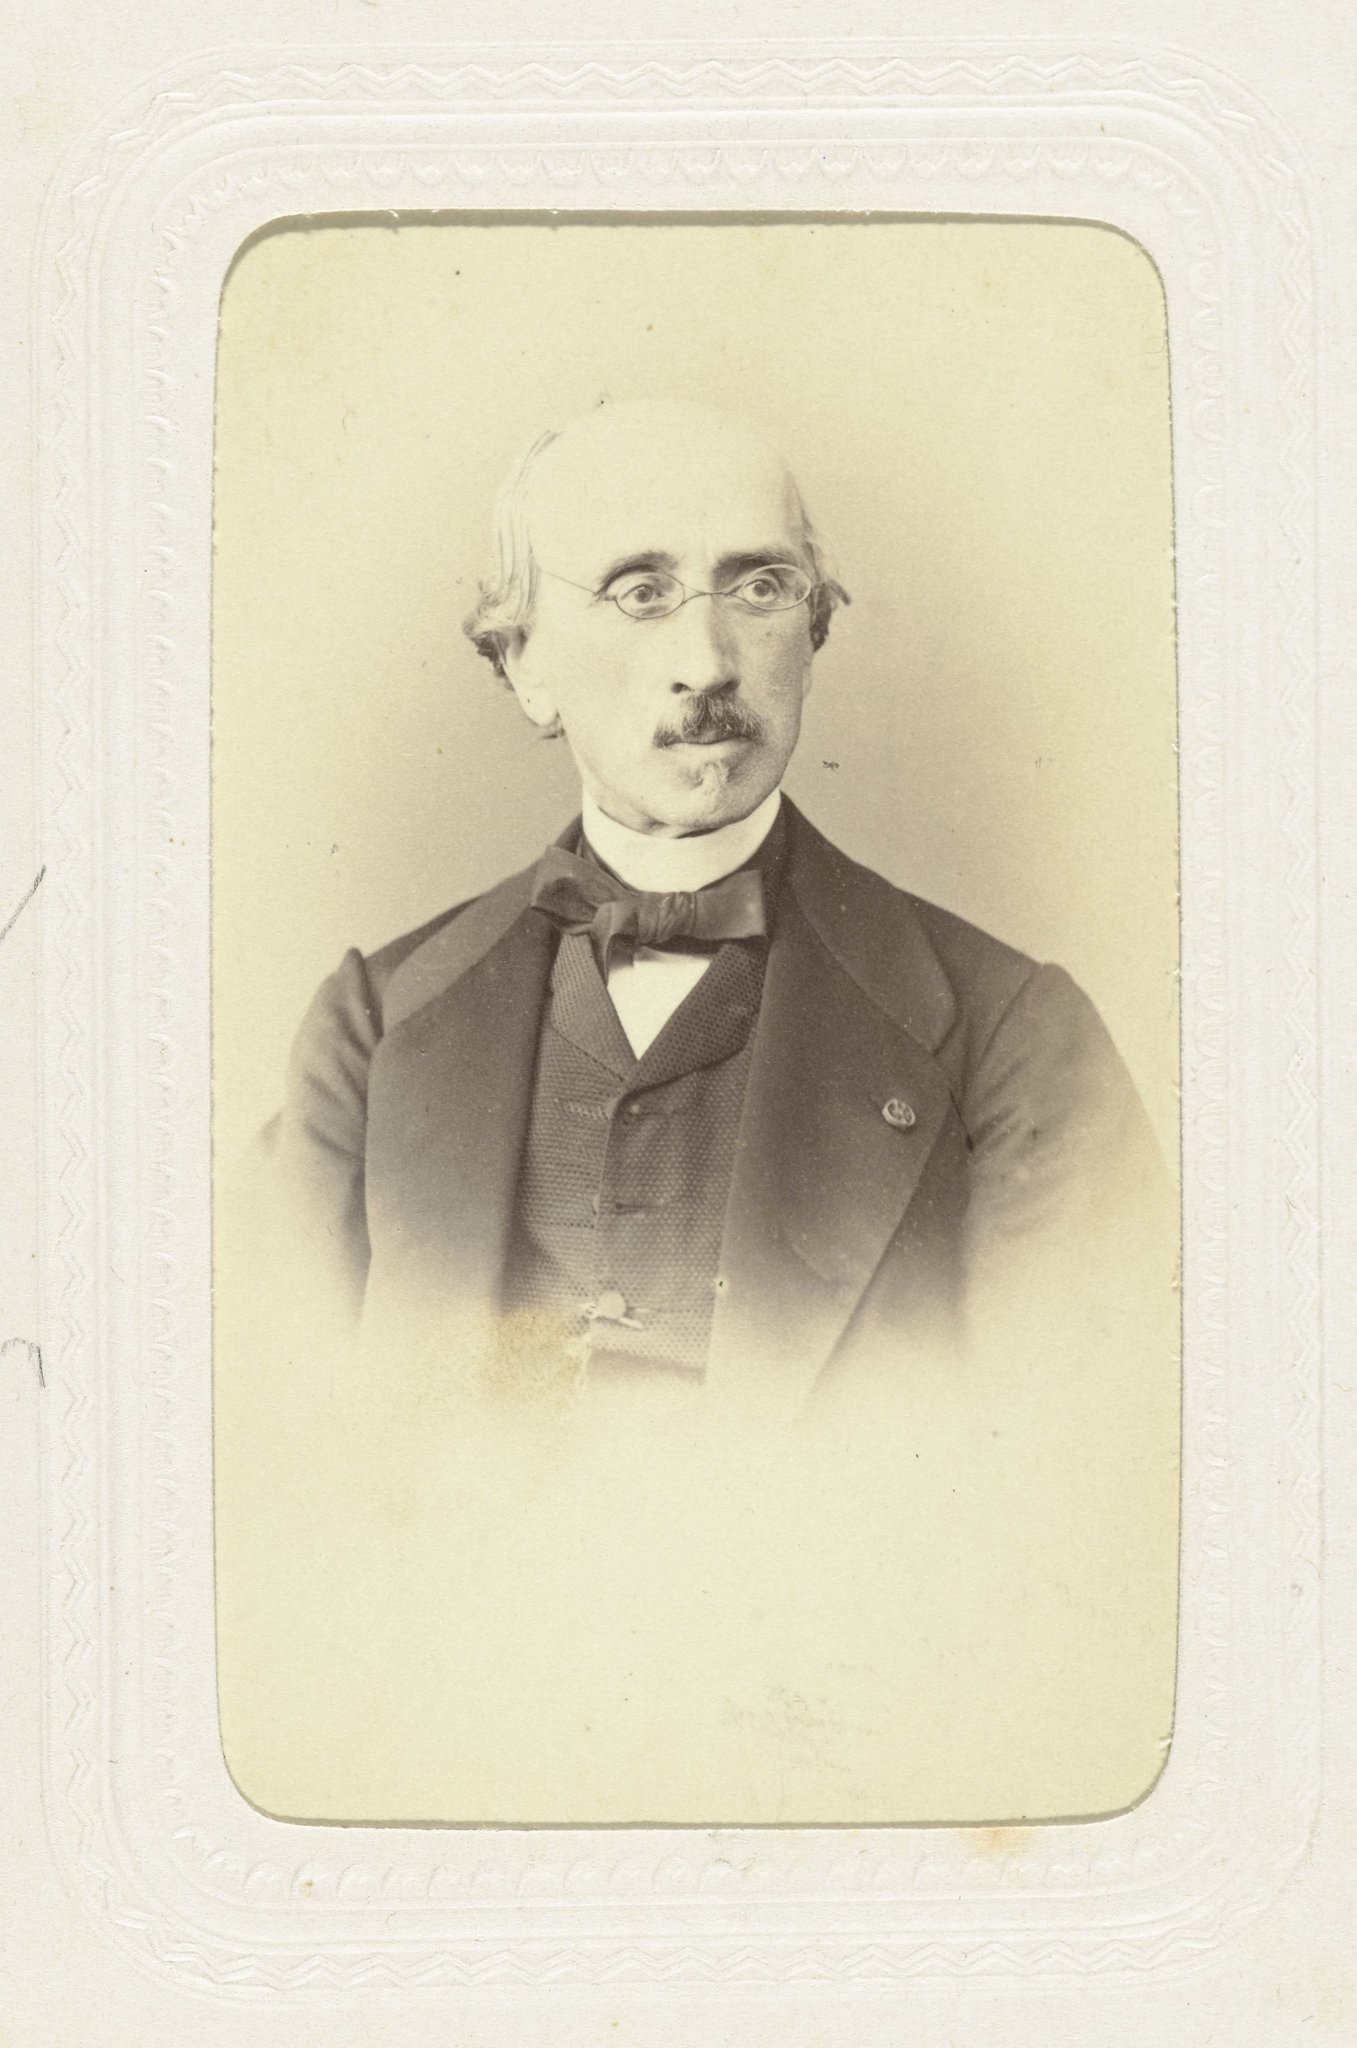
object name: carte de visite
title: Studioportret van een kalende man met een bril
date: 1863-1866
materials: cardboard, paper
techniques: albumen print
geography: istanbul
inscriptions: name: ‘Abdullah freres, Constantinople’